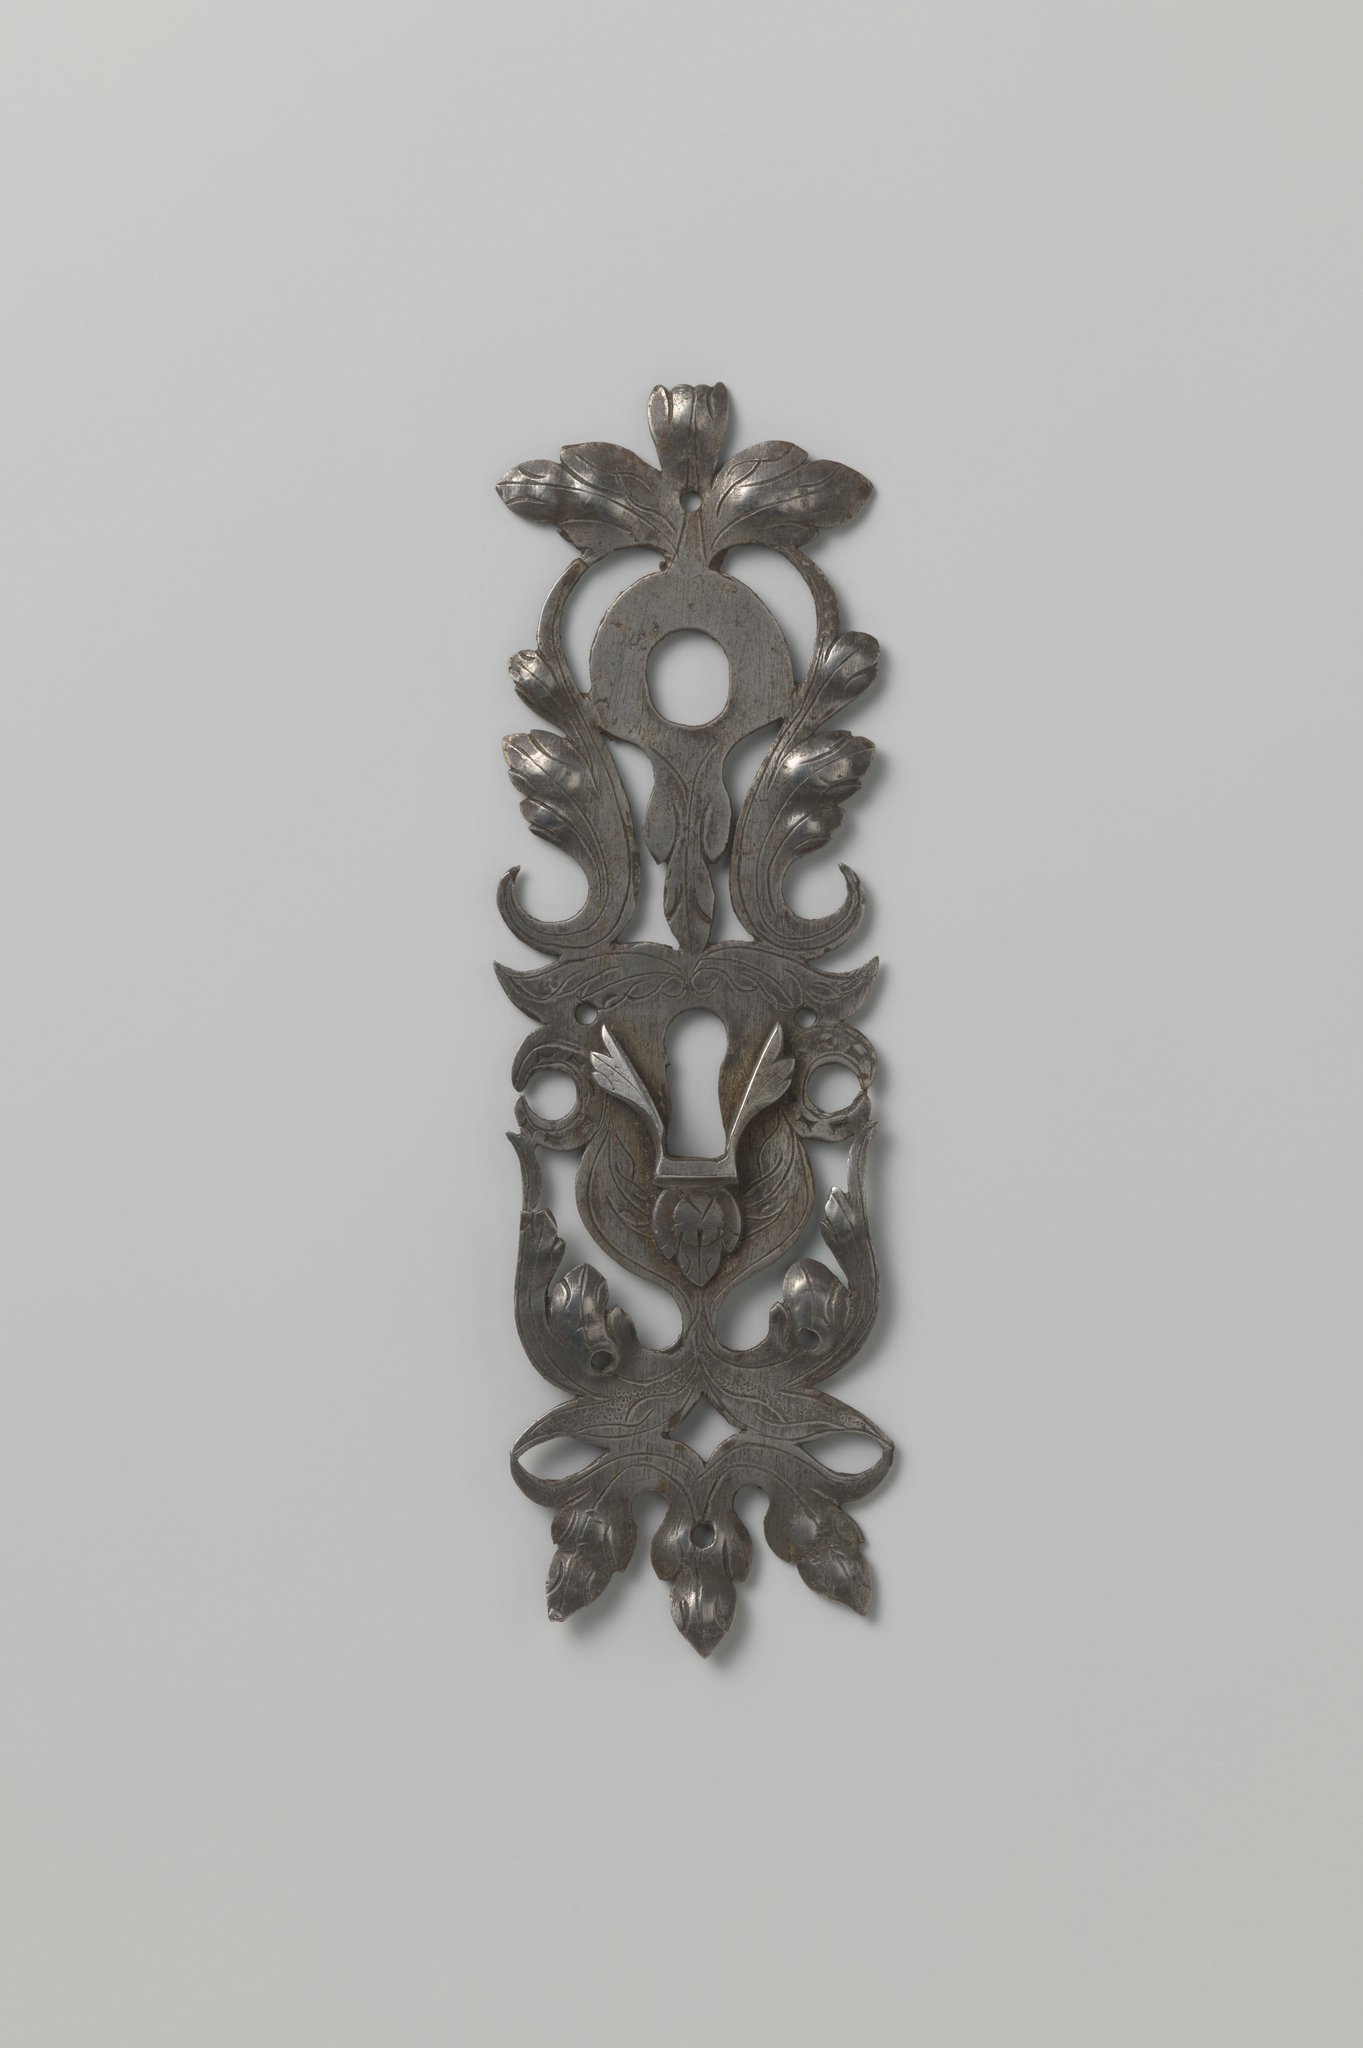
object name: slotplaat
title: Slotplaat versierd met bladmotieven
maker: Anonymous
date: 1600-1800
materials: iron, tin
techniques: metalworking, engraving, forging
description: Opengewerkte slotplaat van vertind ijzer. De onderzijde begint met een omgekeerd drieblad, die overgaan in een omhoog gerichte bladeren en een kelkmotief, waarin het sleutelgat is aangebracht met een uitstekend plaatje eronder. Daarboven twee S-voluten rond een blad met in het midden een ronde opening. De bovenzijde wordt bekroond met een drieblad.